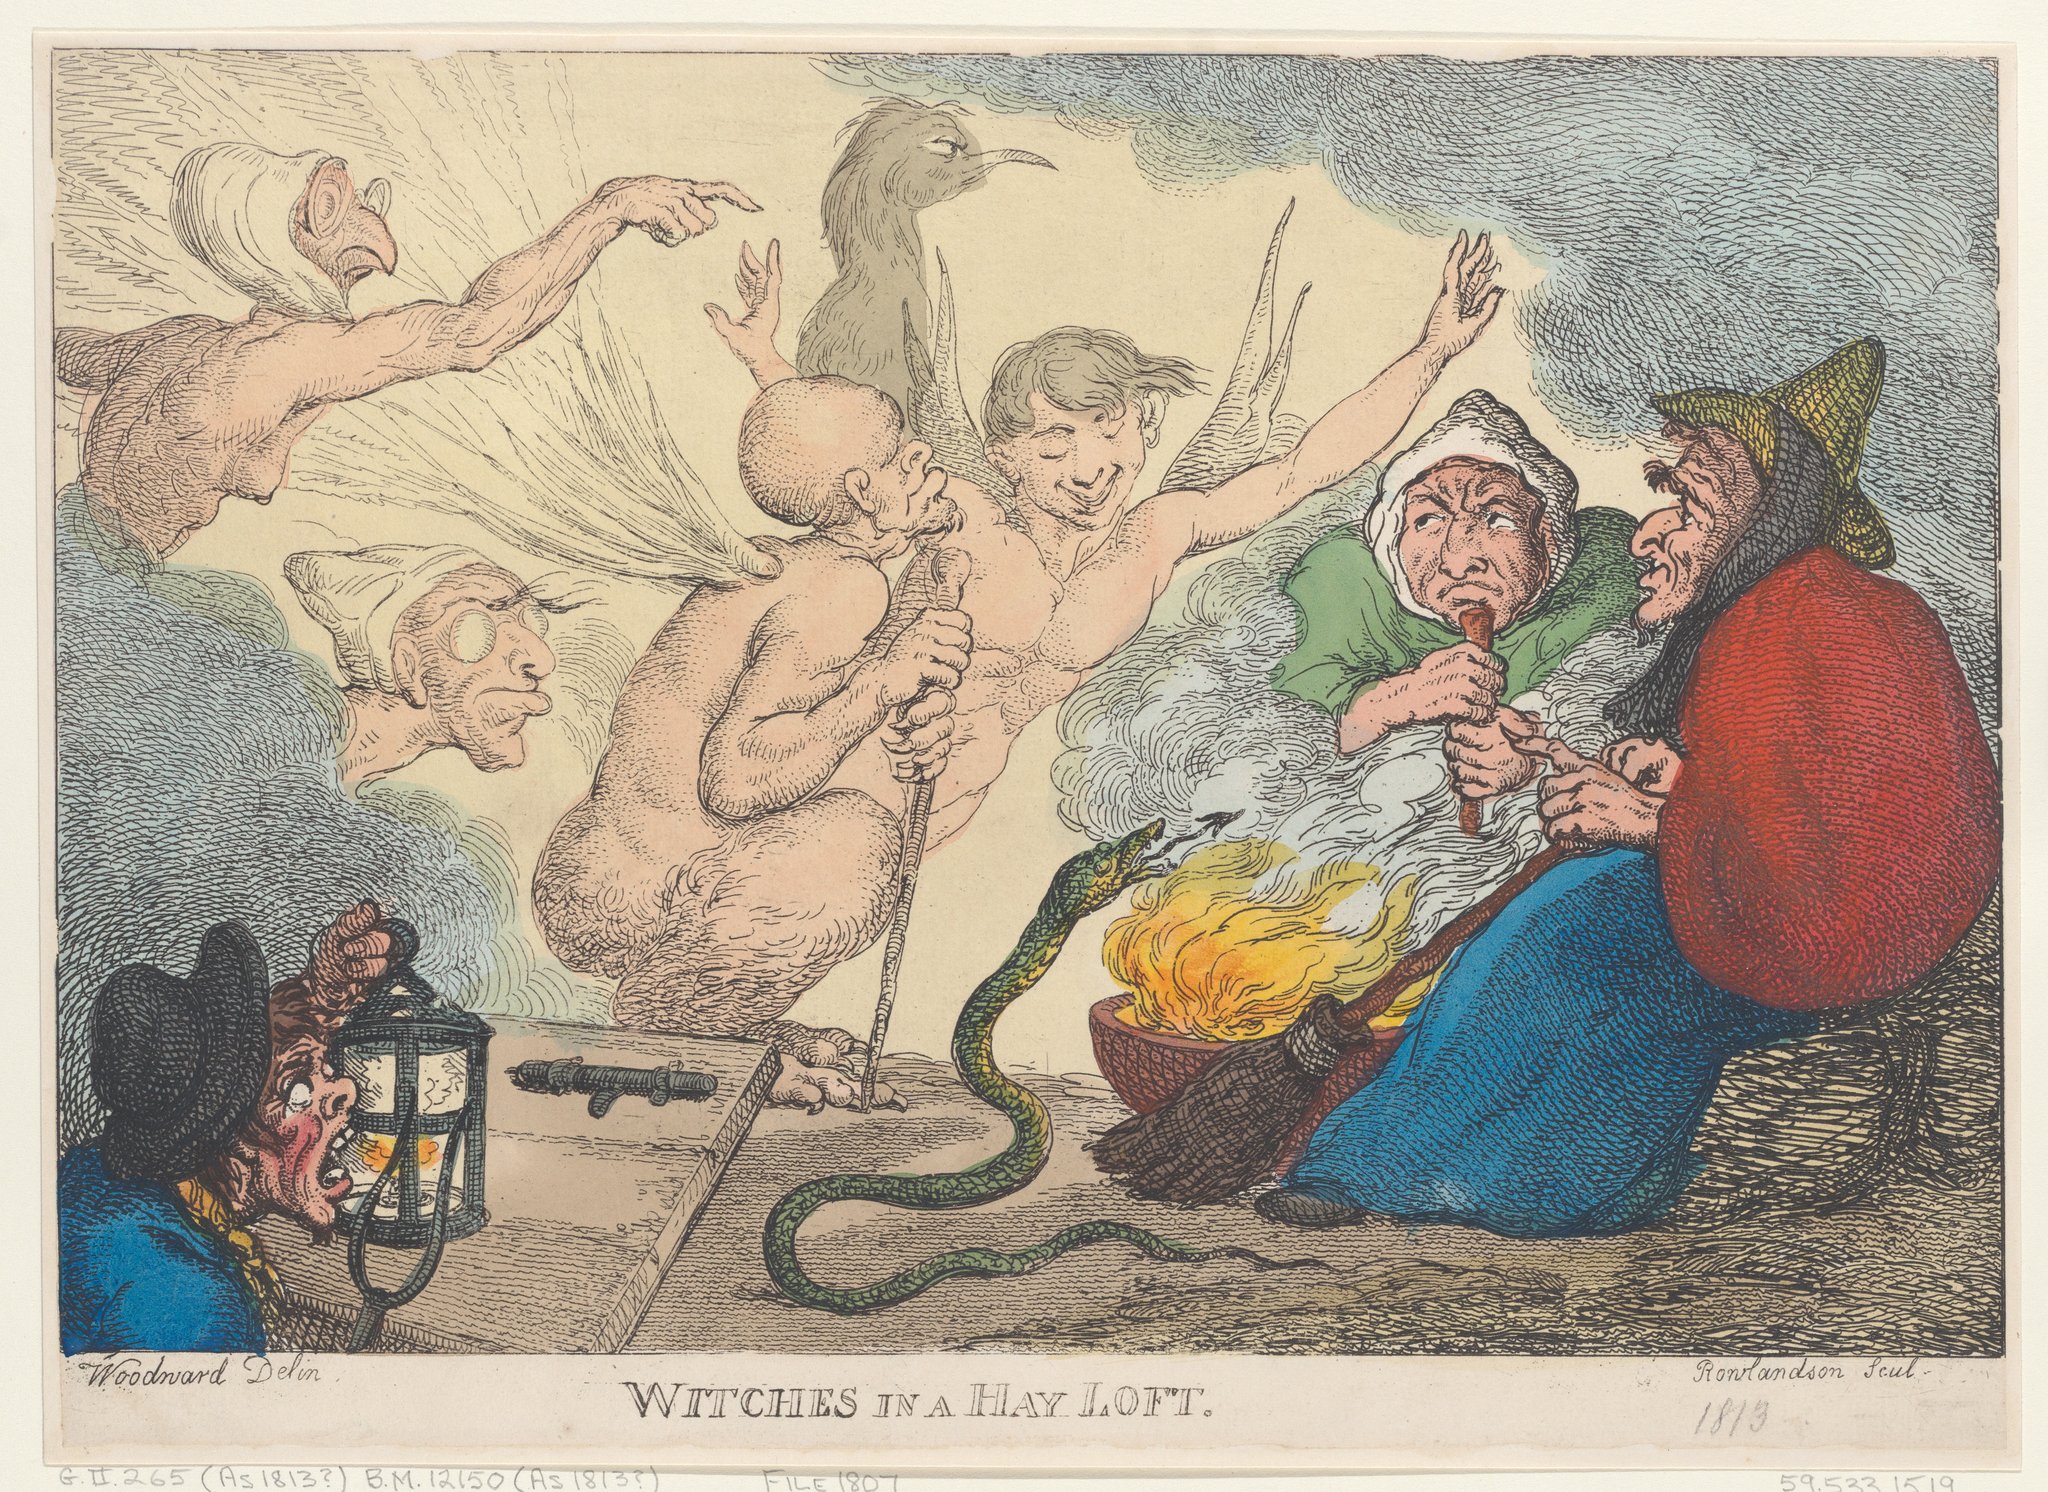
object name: print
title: Witches in a Hay Loft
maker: thomas rowlandson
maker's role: artist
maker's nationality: british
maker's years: 1757-1827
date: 1807-1813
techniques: etching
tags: satire,men,women,monsters,snakes,witches